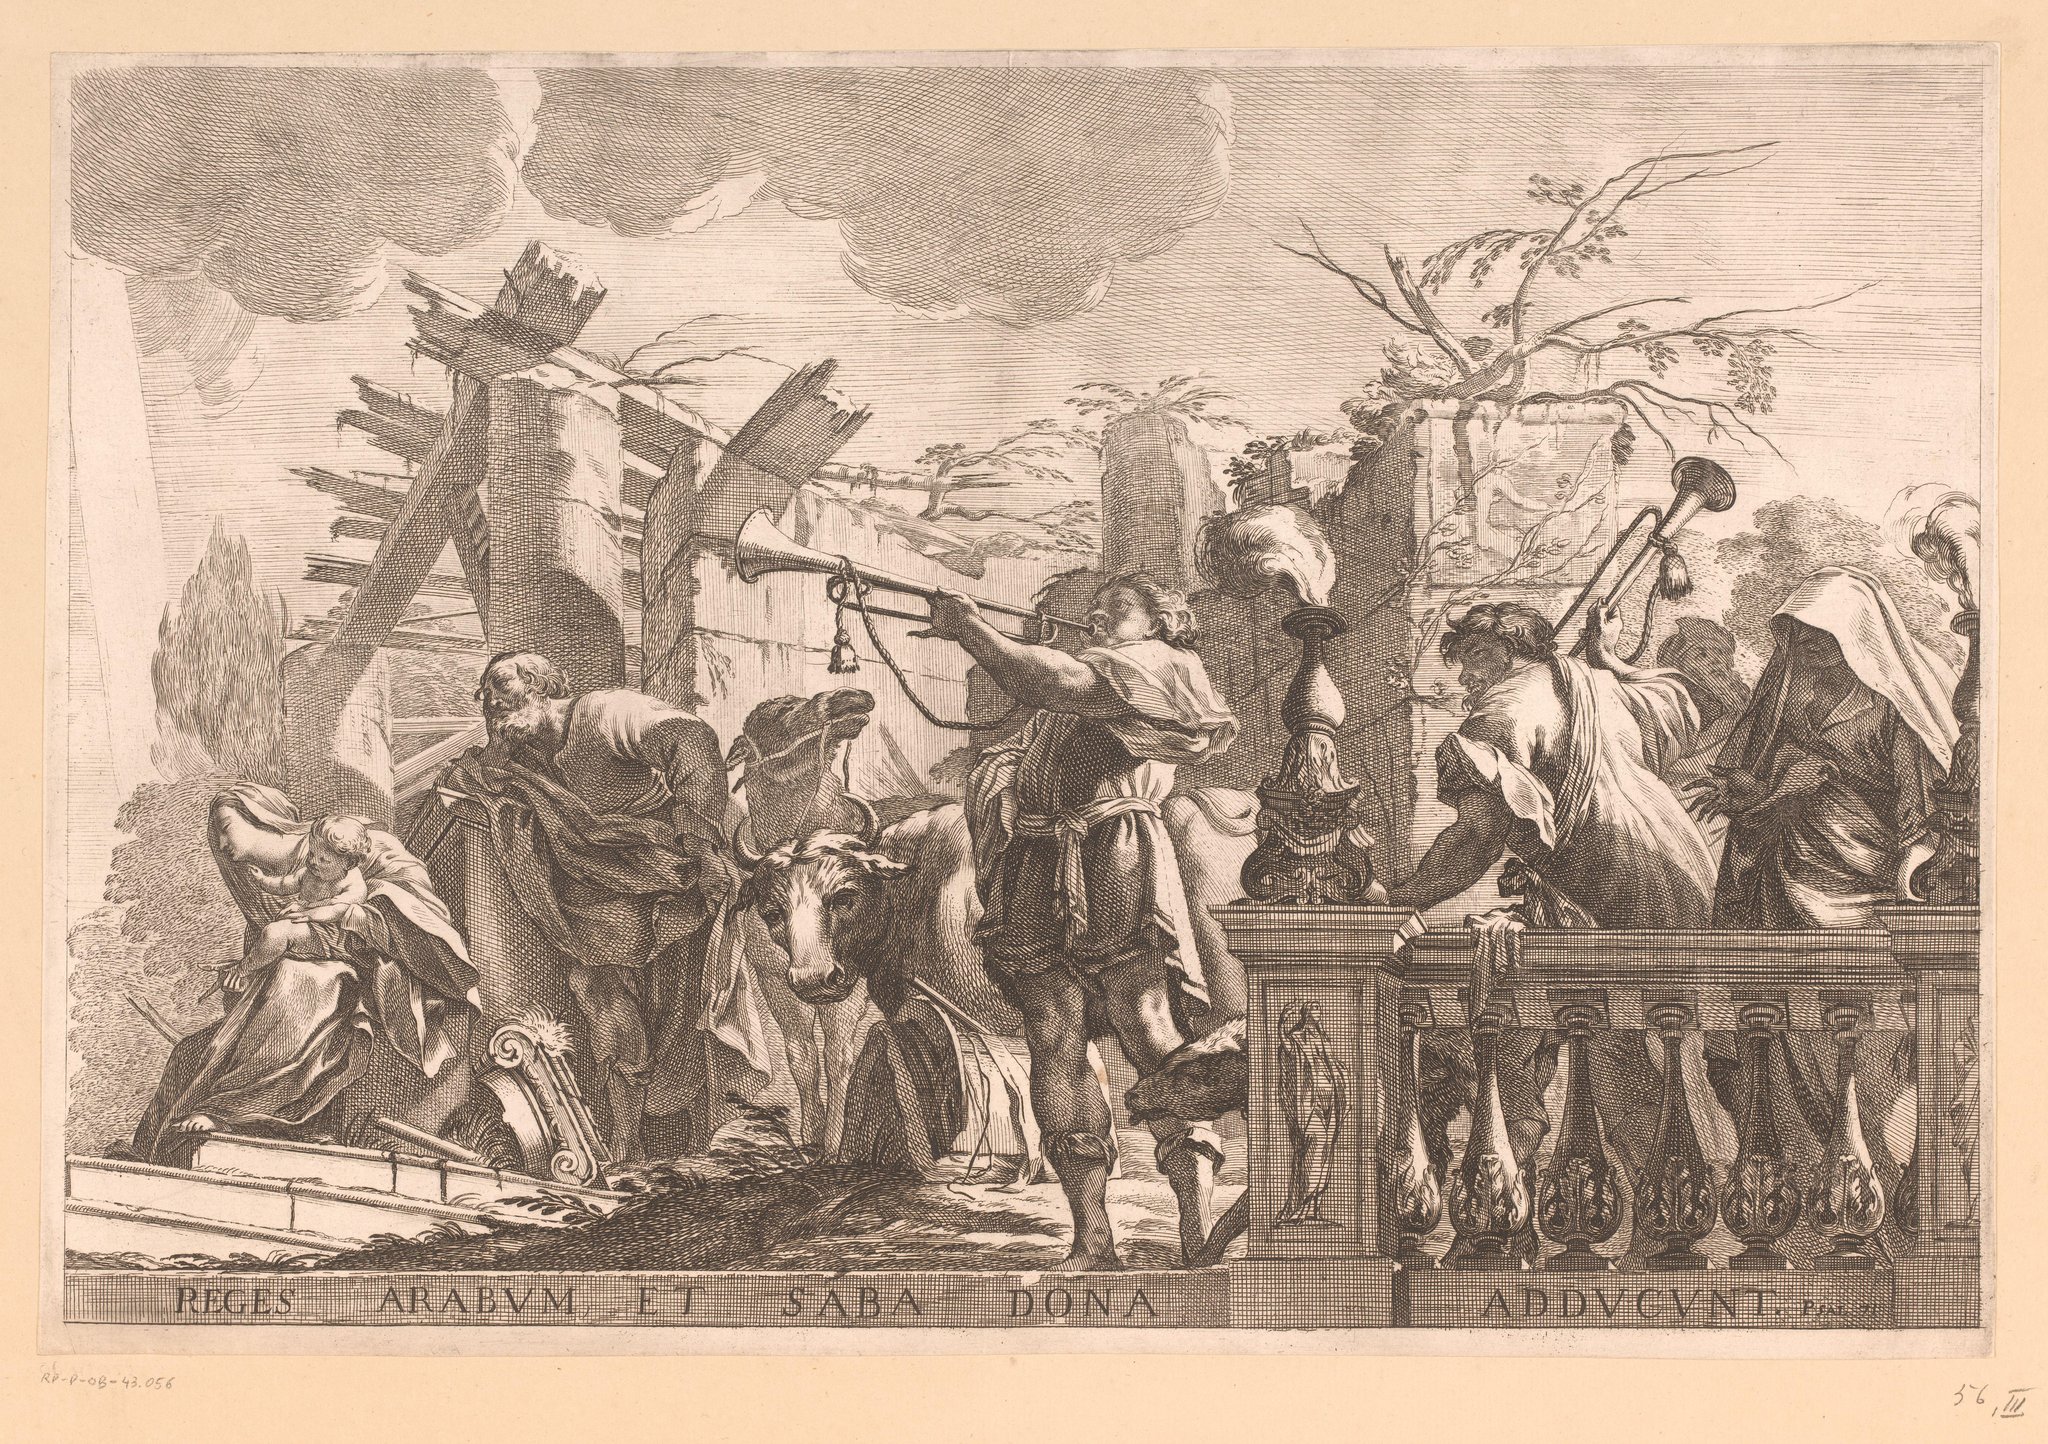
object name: print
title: Aanbidding door de koningen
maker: michel dorigny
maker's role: draughtsman, painter, print maker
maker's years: 1616-1665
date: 1638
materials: paper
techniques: engraving, etching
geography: france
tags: adoration of the kings: the wise men present their gifts to the christ-child (gold, frankincense and myrrh)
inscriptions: collector's mark: Lugt 240